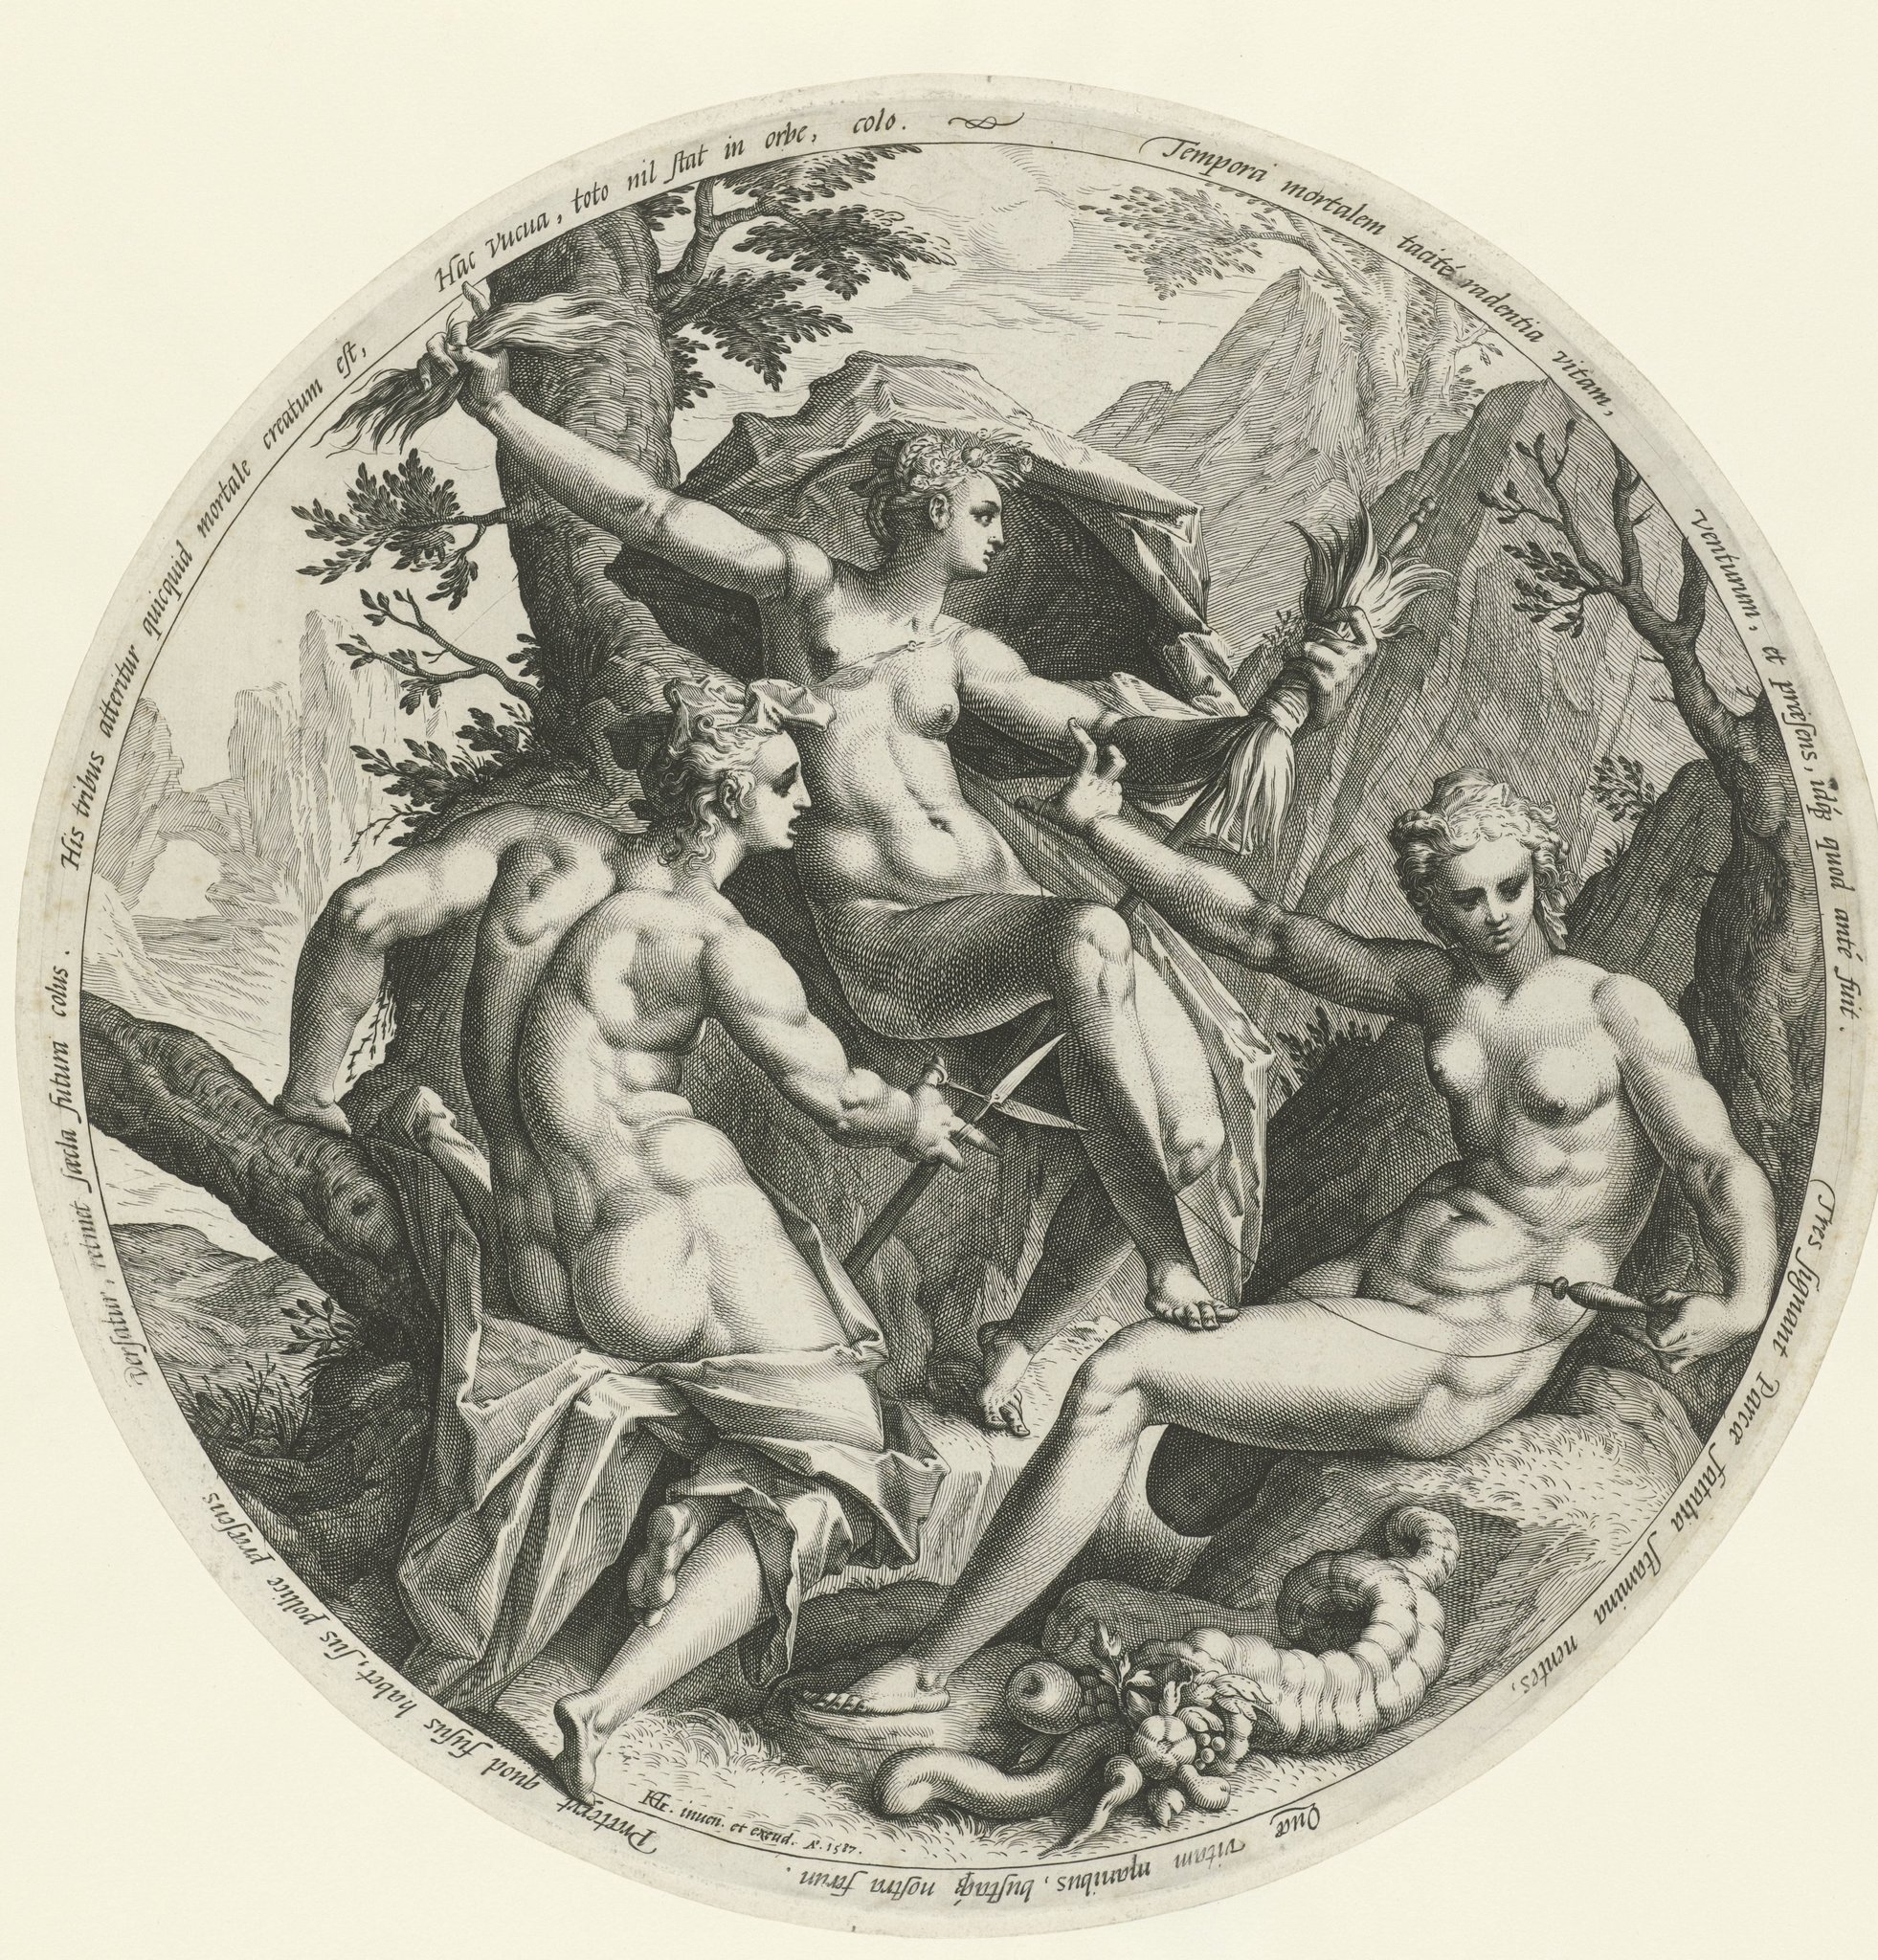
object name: print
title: Drie schikgodinnen in een landschap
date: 1587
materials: paper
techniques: engraving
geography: haarlem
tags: fates, parcae (moirae)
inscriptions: collector's mark: Lugt 240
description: De drie schikgodinnen in een landschap. In het midden de schikgodin Clotho die het spinrok vasthoudt, met in haar andere hand het ruwe vlas. Rechts, De zittende Lachesis heeft de klos vast en meet de draad. De linker schikgodin, Atropos, knipt met een schaar de draad door.